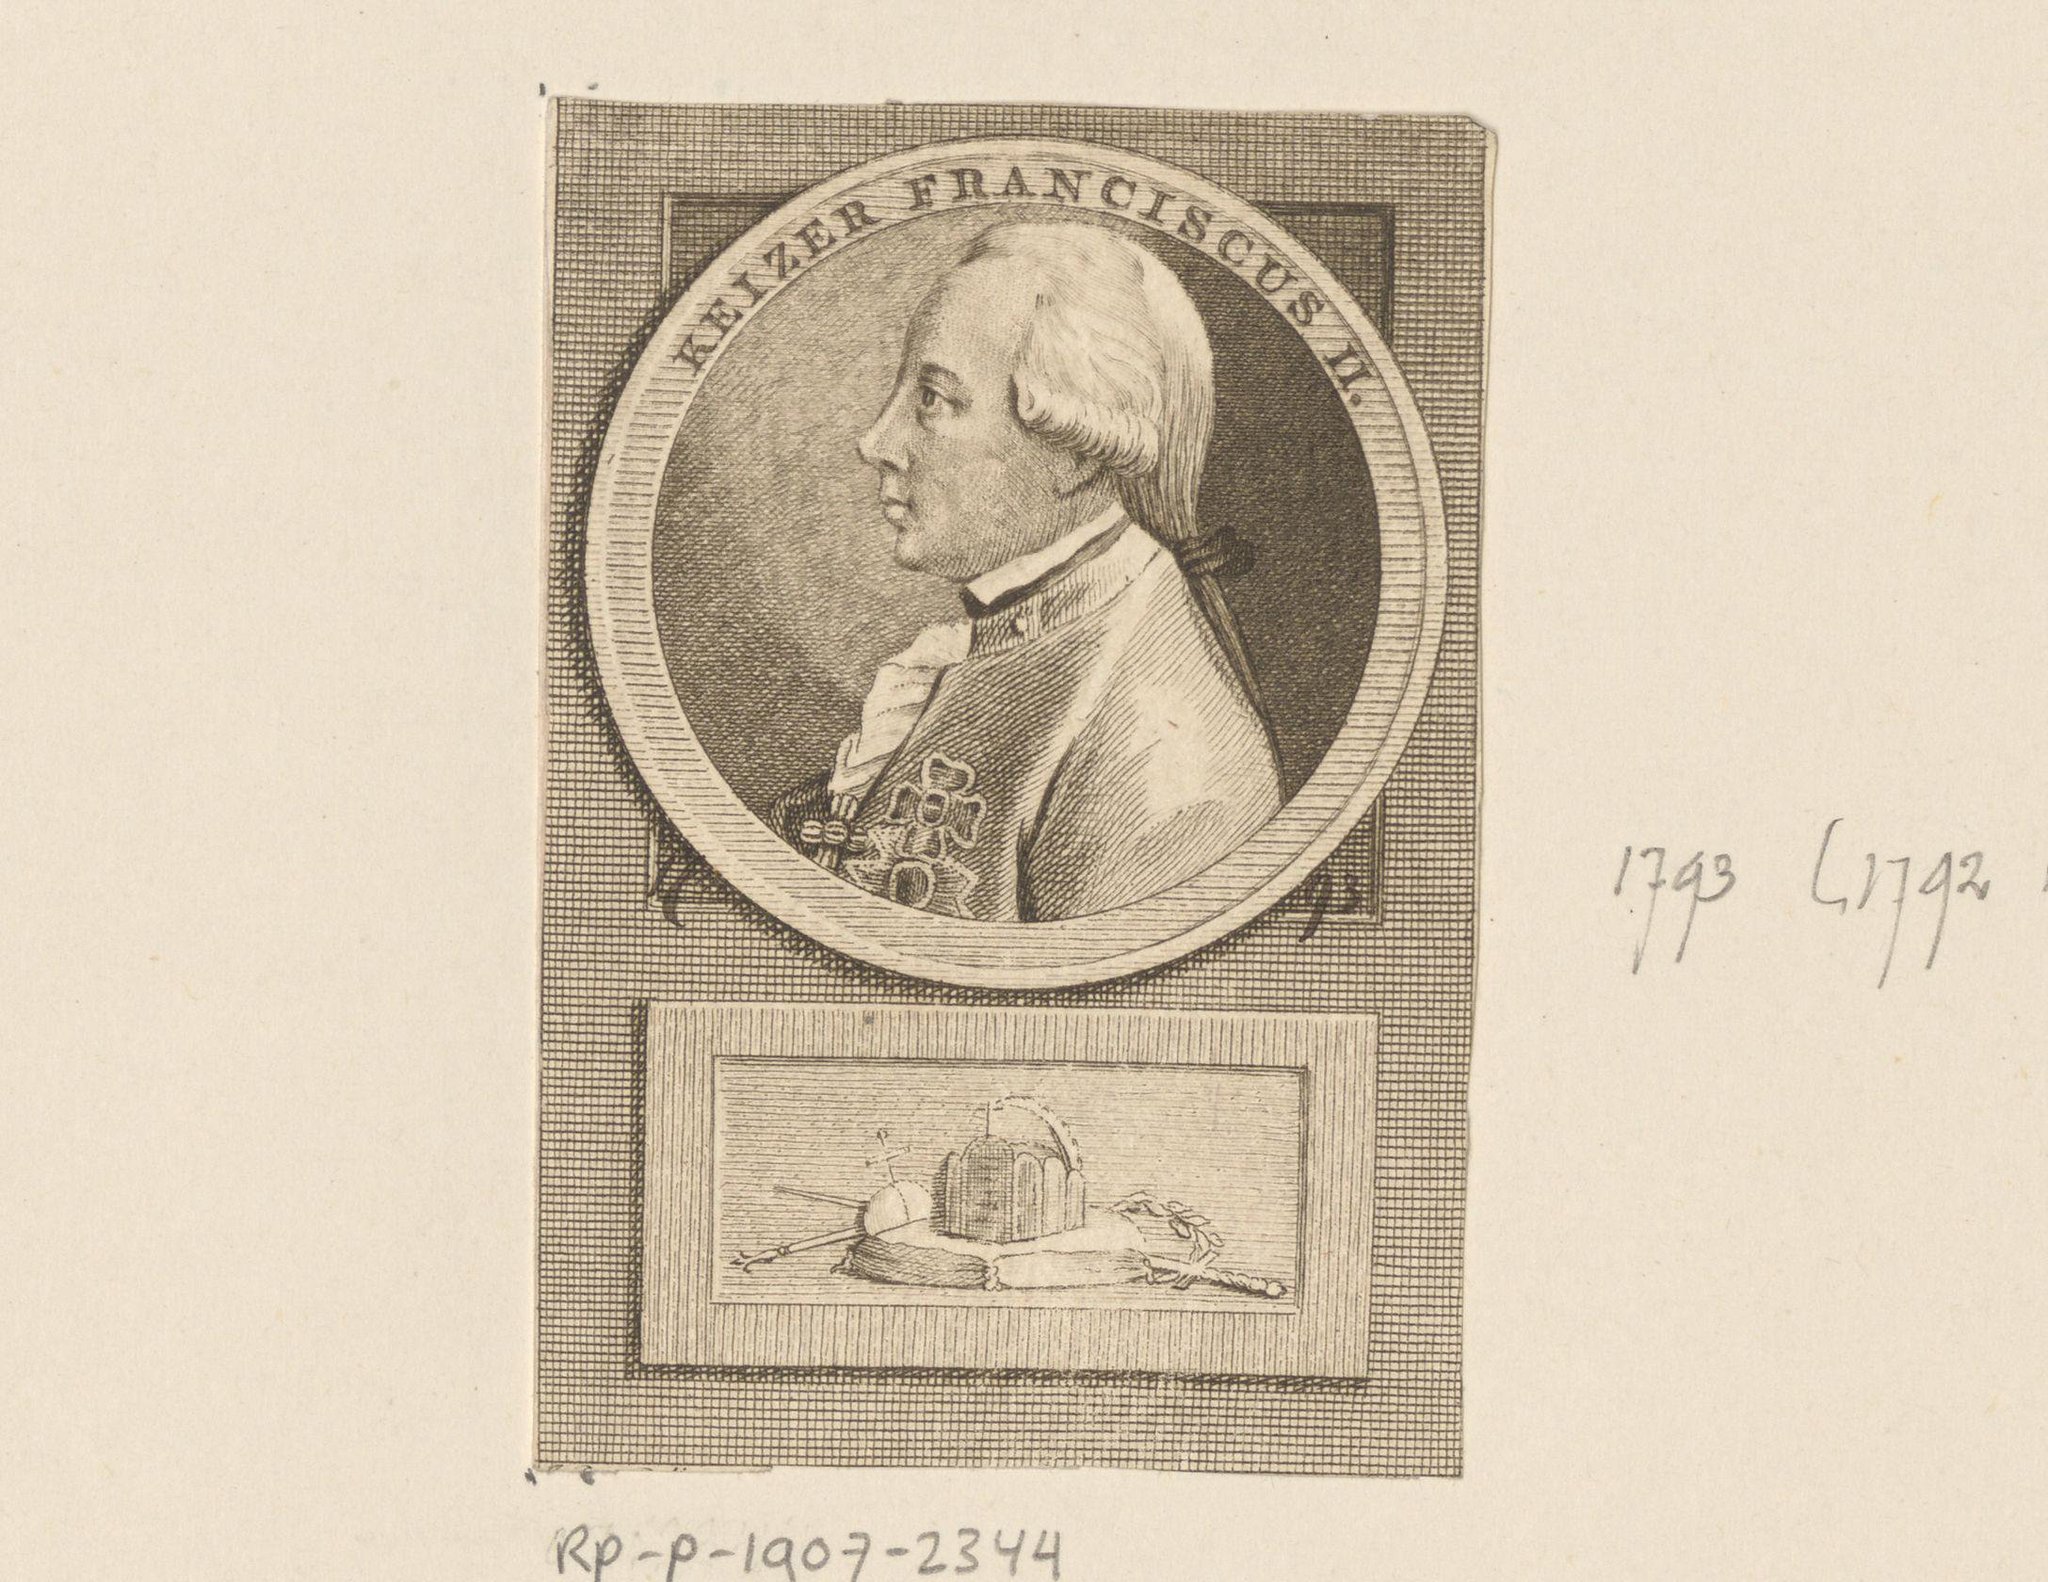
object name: print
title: Portret van keizer Frans II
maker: cornelis bogerts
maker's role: print maker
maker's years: 1745-1817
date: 1795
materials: paper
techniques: etching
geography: amsterdam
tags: frans ii (rooms-duits keizer), crown (symbol of sovereignty), orb (symbol of sovereignty; sphere with cross on top), sceptre, staff (symbol of sovereignty), historical persons, hacking and thrusting weapons: sword, emperor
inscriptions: collector's mark: Lugt 2228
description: Prent waarschijnlijk uit: Fokke, Jan. Geschiedenissen der Vereenigde Nederlanden voor de vaderlandsche jeugd. Amsterdam: Johannes Allart, 1795, dl. 24.